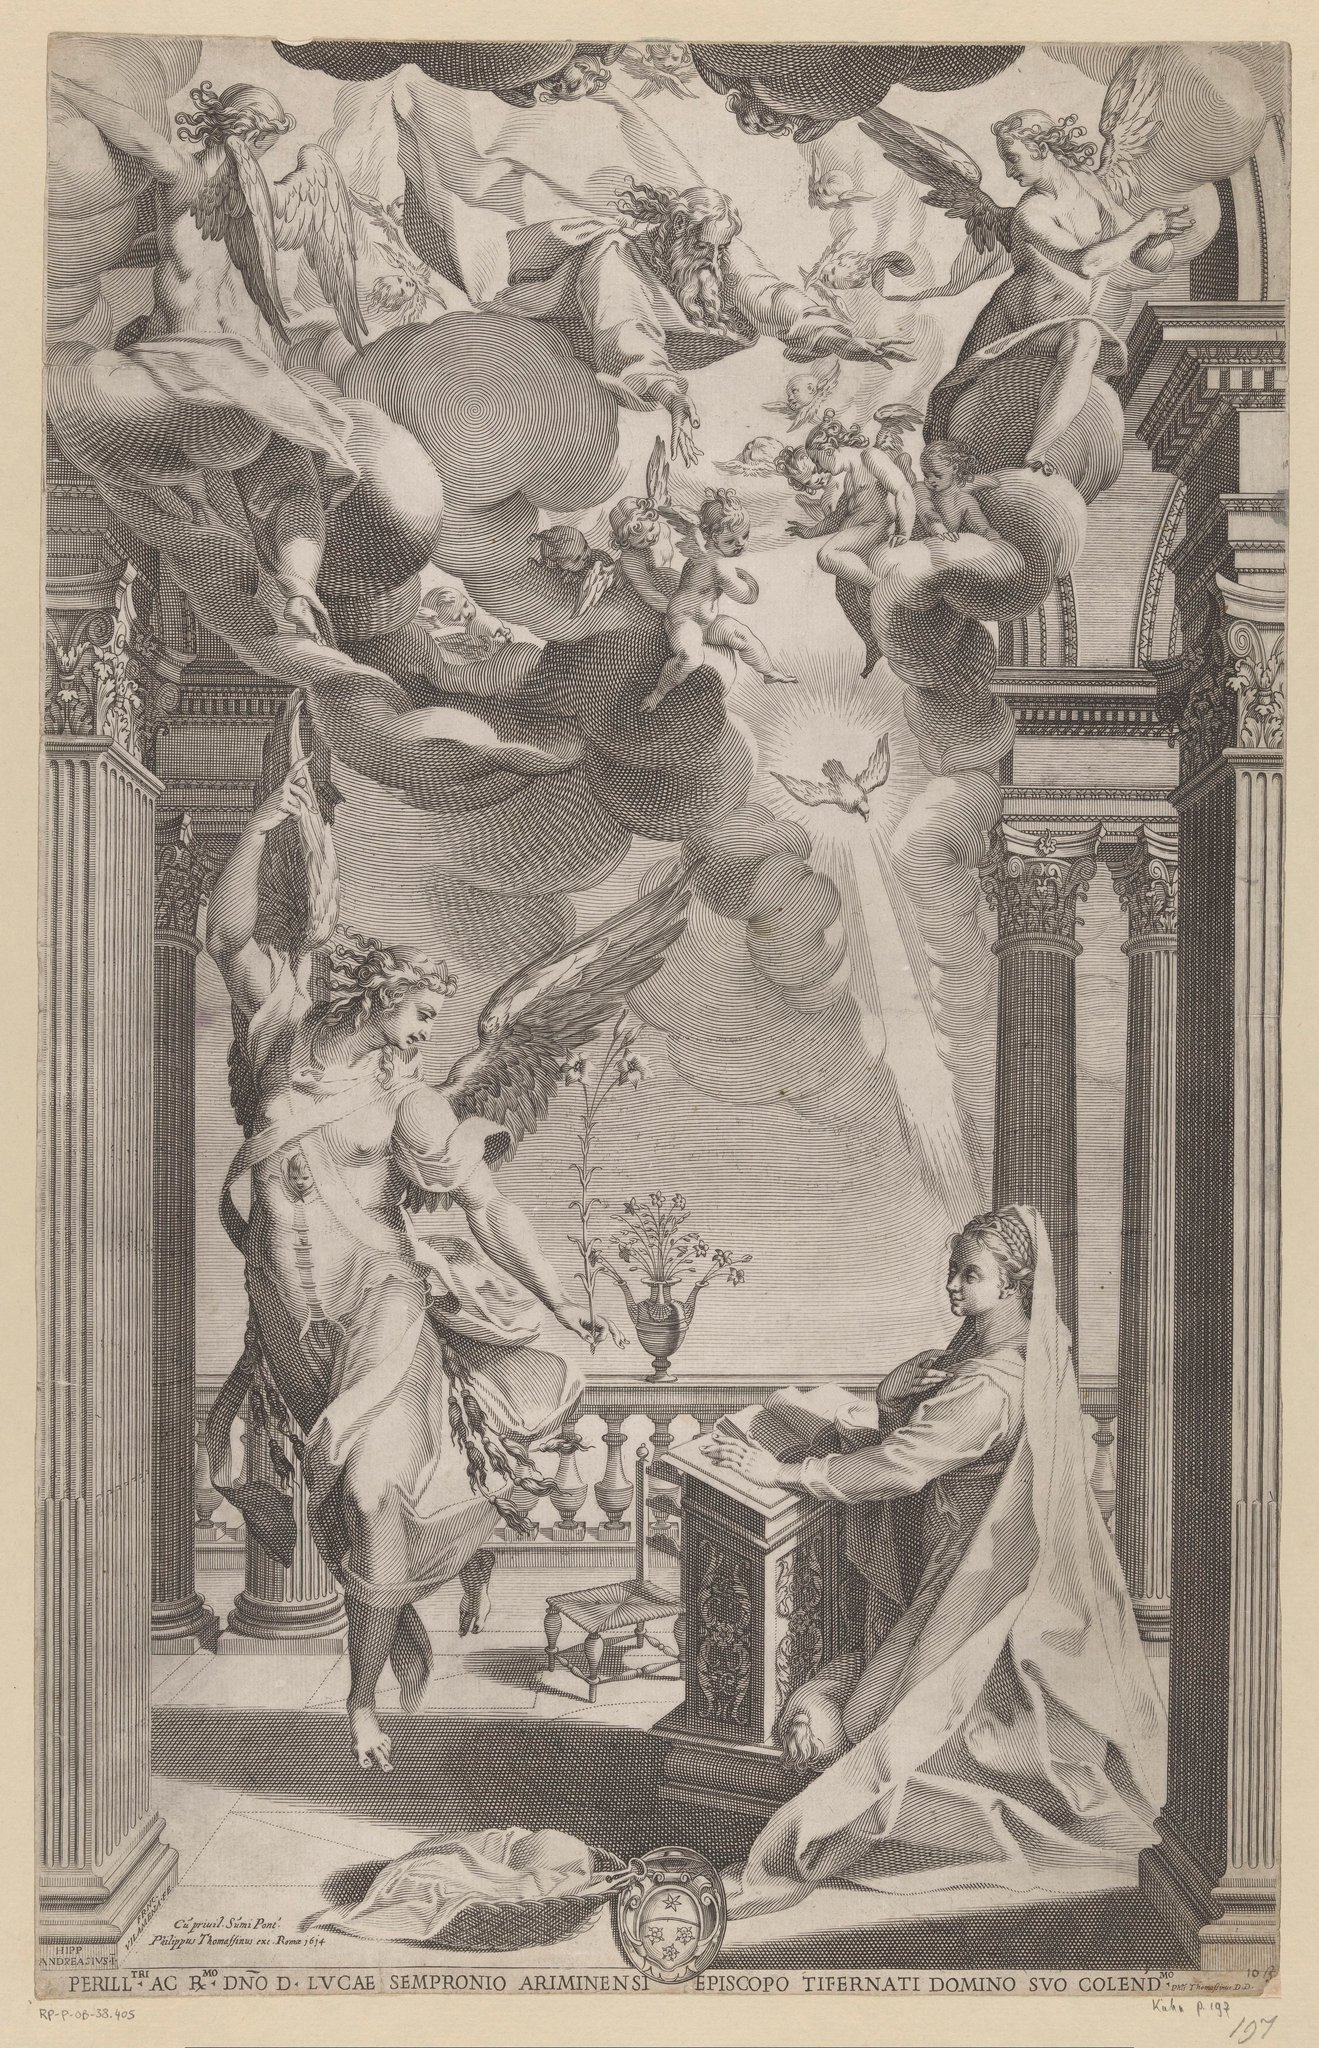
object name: print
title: Annunciatie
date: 1614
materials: paper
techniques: engraving, etching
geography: rome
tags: cherubs, i.e. children's heads with wings, the annunciation: mary, usually reading, is visited by the angel (sometimes a woman overhears the conversation), angels, holy ghost represented as a dove (in flames)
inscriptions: collector's mark: Lugt 240, inscription: ‘10B’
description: In een architectonische ruimte kondigt de engel Gabriël aan Maria aan dat ze zwanger zal worden. Maria zit achter een lessenaar terwijl de engel Gabriël aan haar verschijnt met een lelie in de hand. In de lucht de Heilige Geest als duif en God de Vader omgeven door engelen en cherubijnen. Opdracht en wapenschild in ondermarge.